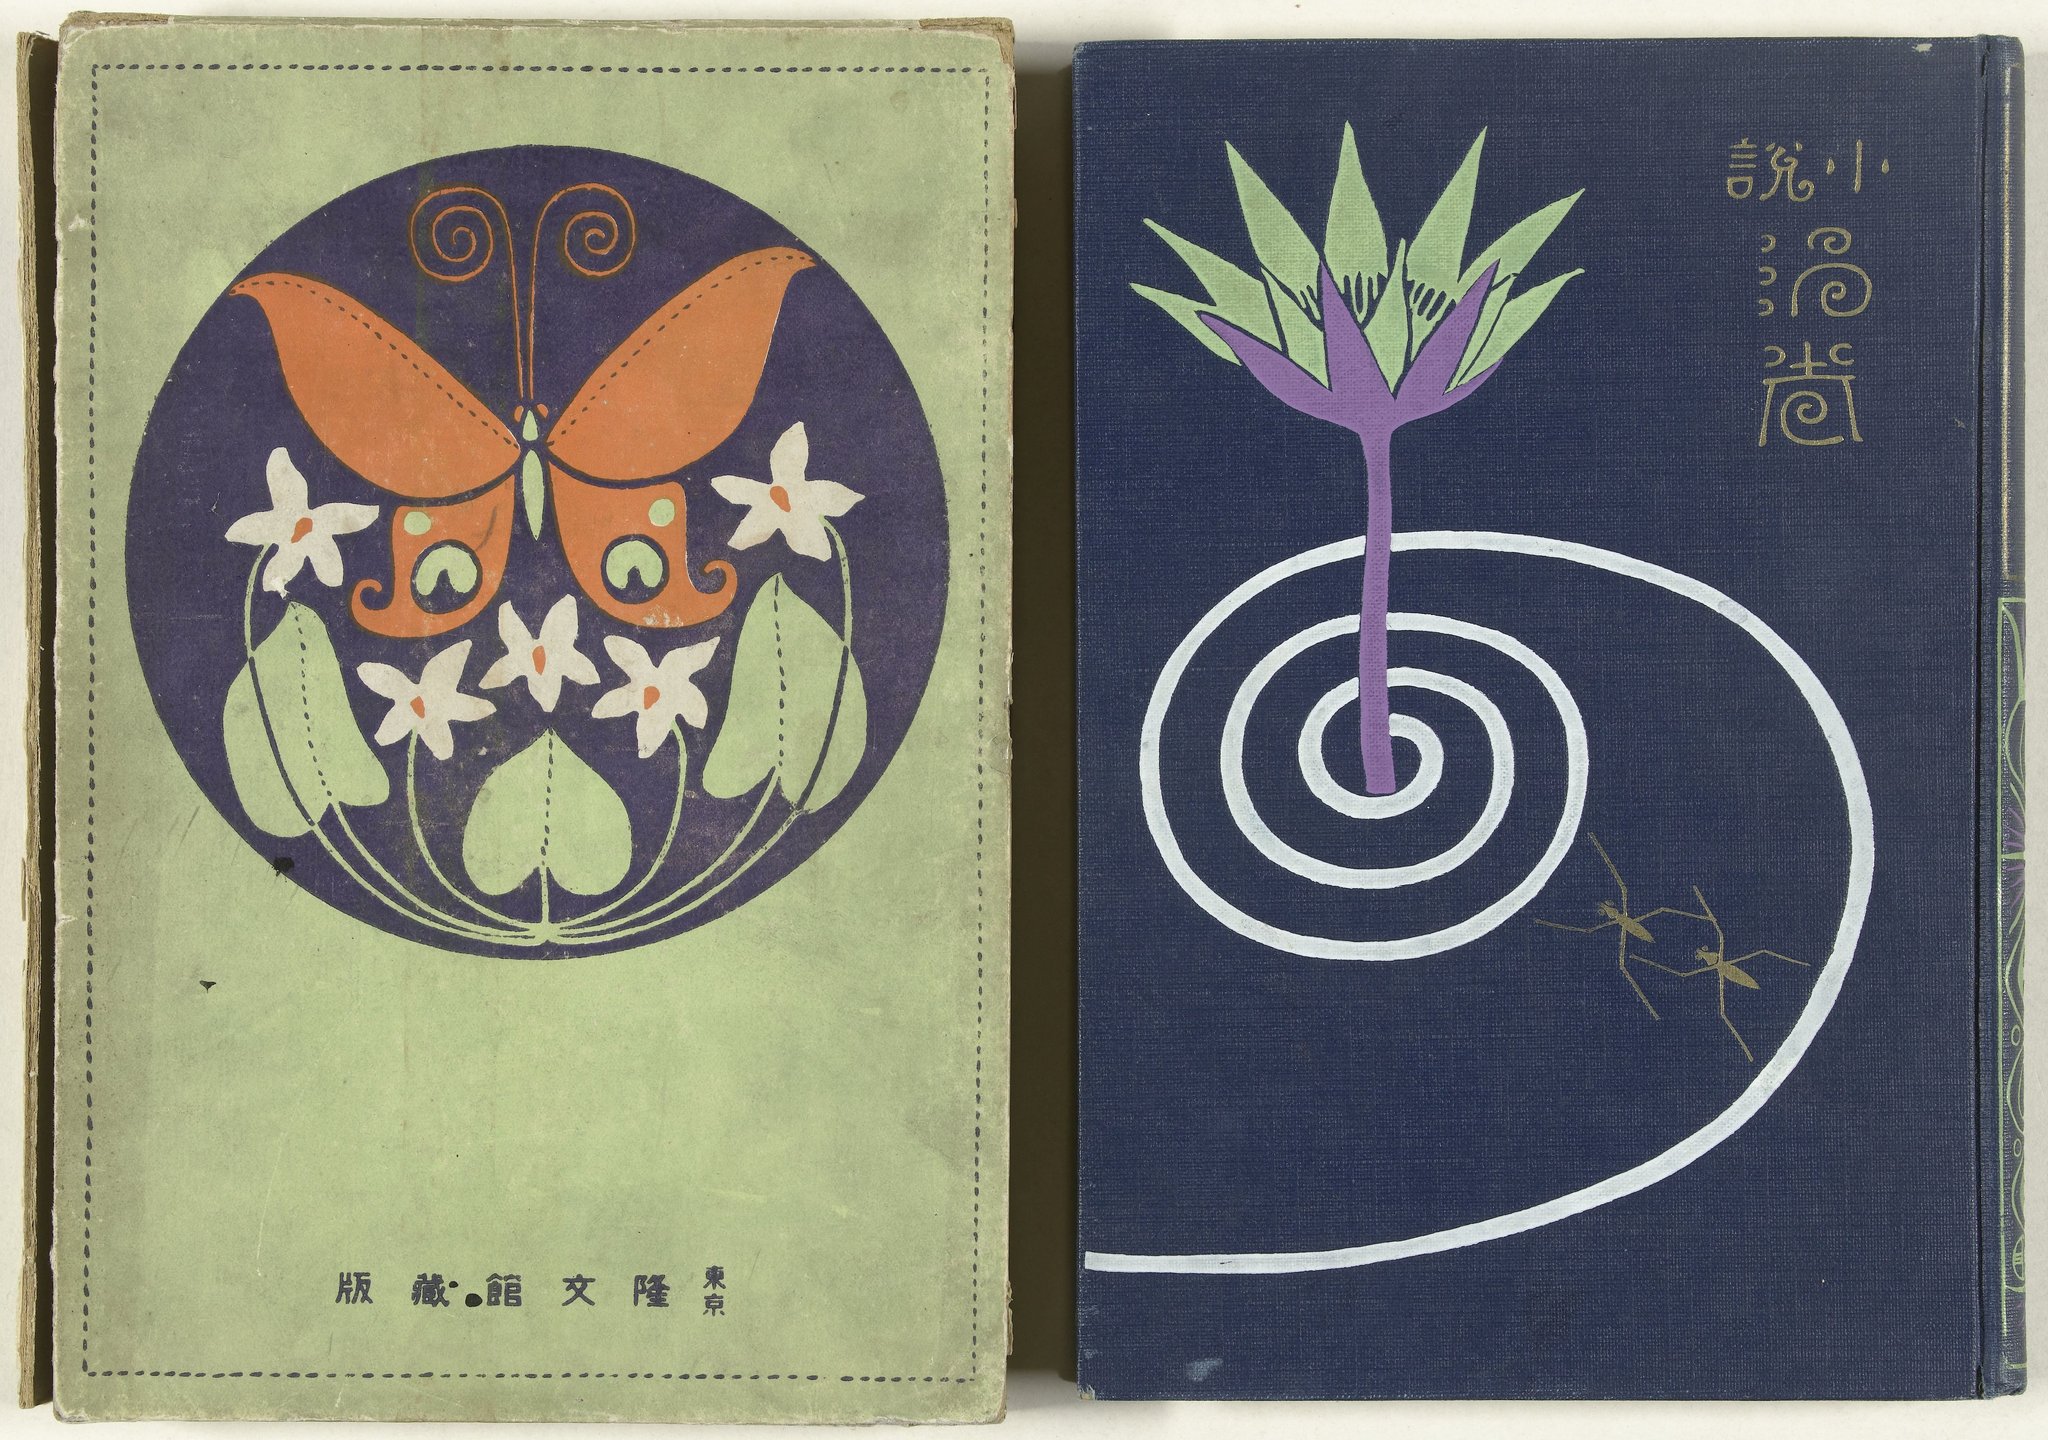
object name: book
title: Draaikolken - vervolg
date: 1914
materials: paper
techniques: woodcut, letterpress printing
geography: tokyo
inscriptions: date